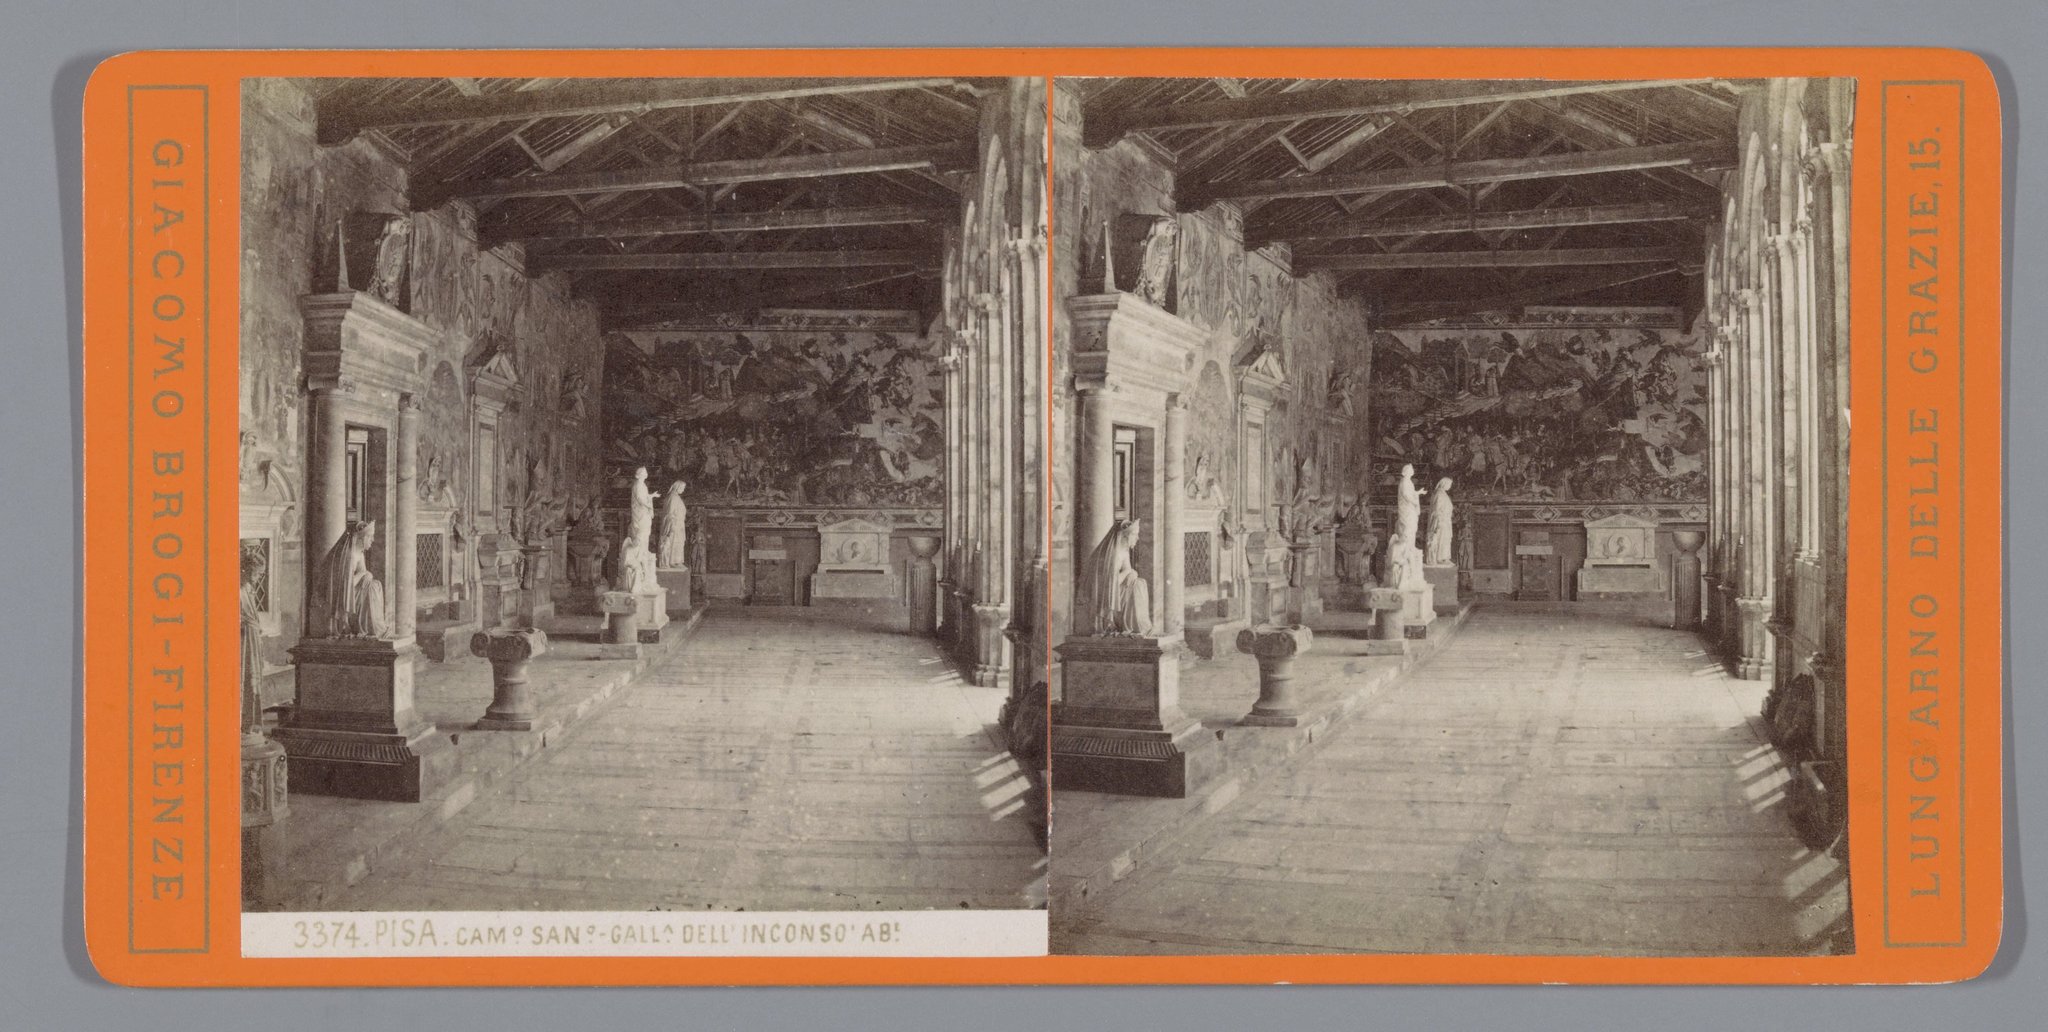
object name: stereograph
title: Galerij met archeologische vondsten aan het Camposanto, Pisa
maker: giacomo brogi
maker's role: fotograaf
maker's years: 1822-1881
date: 1865-1881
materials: cardboard, paper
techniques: albumen print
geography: pisa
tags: gallery (spacious corridor), sculpture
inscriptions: number: ‘3374.’, address: ‘Lung'Arno delle Grazie, 15.’